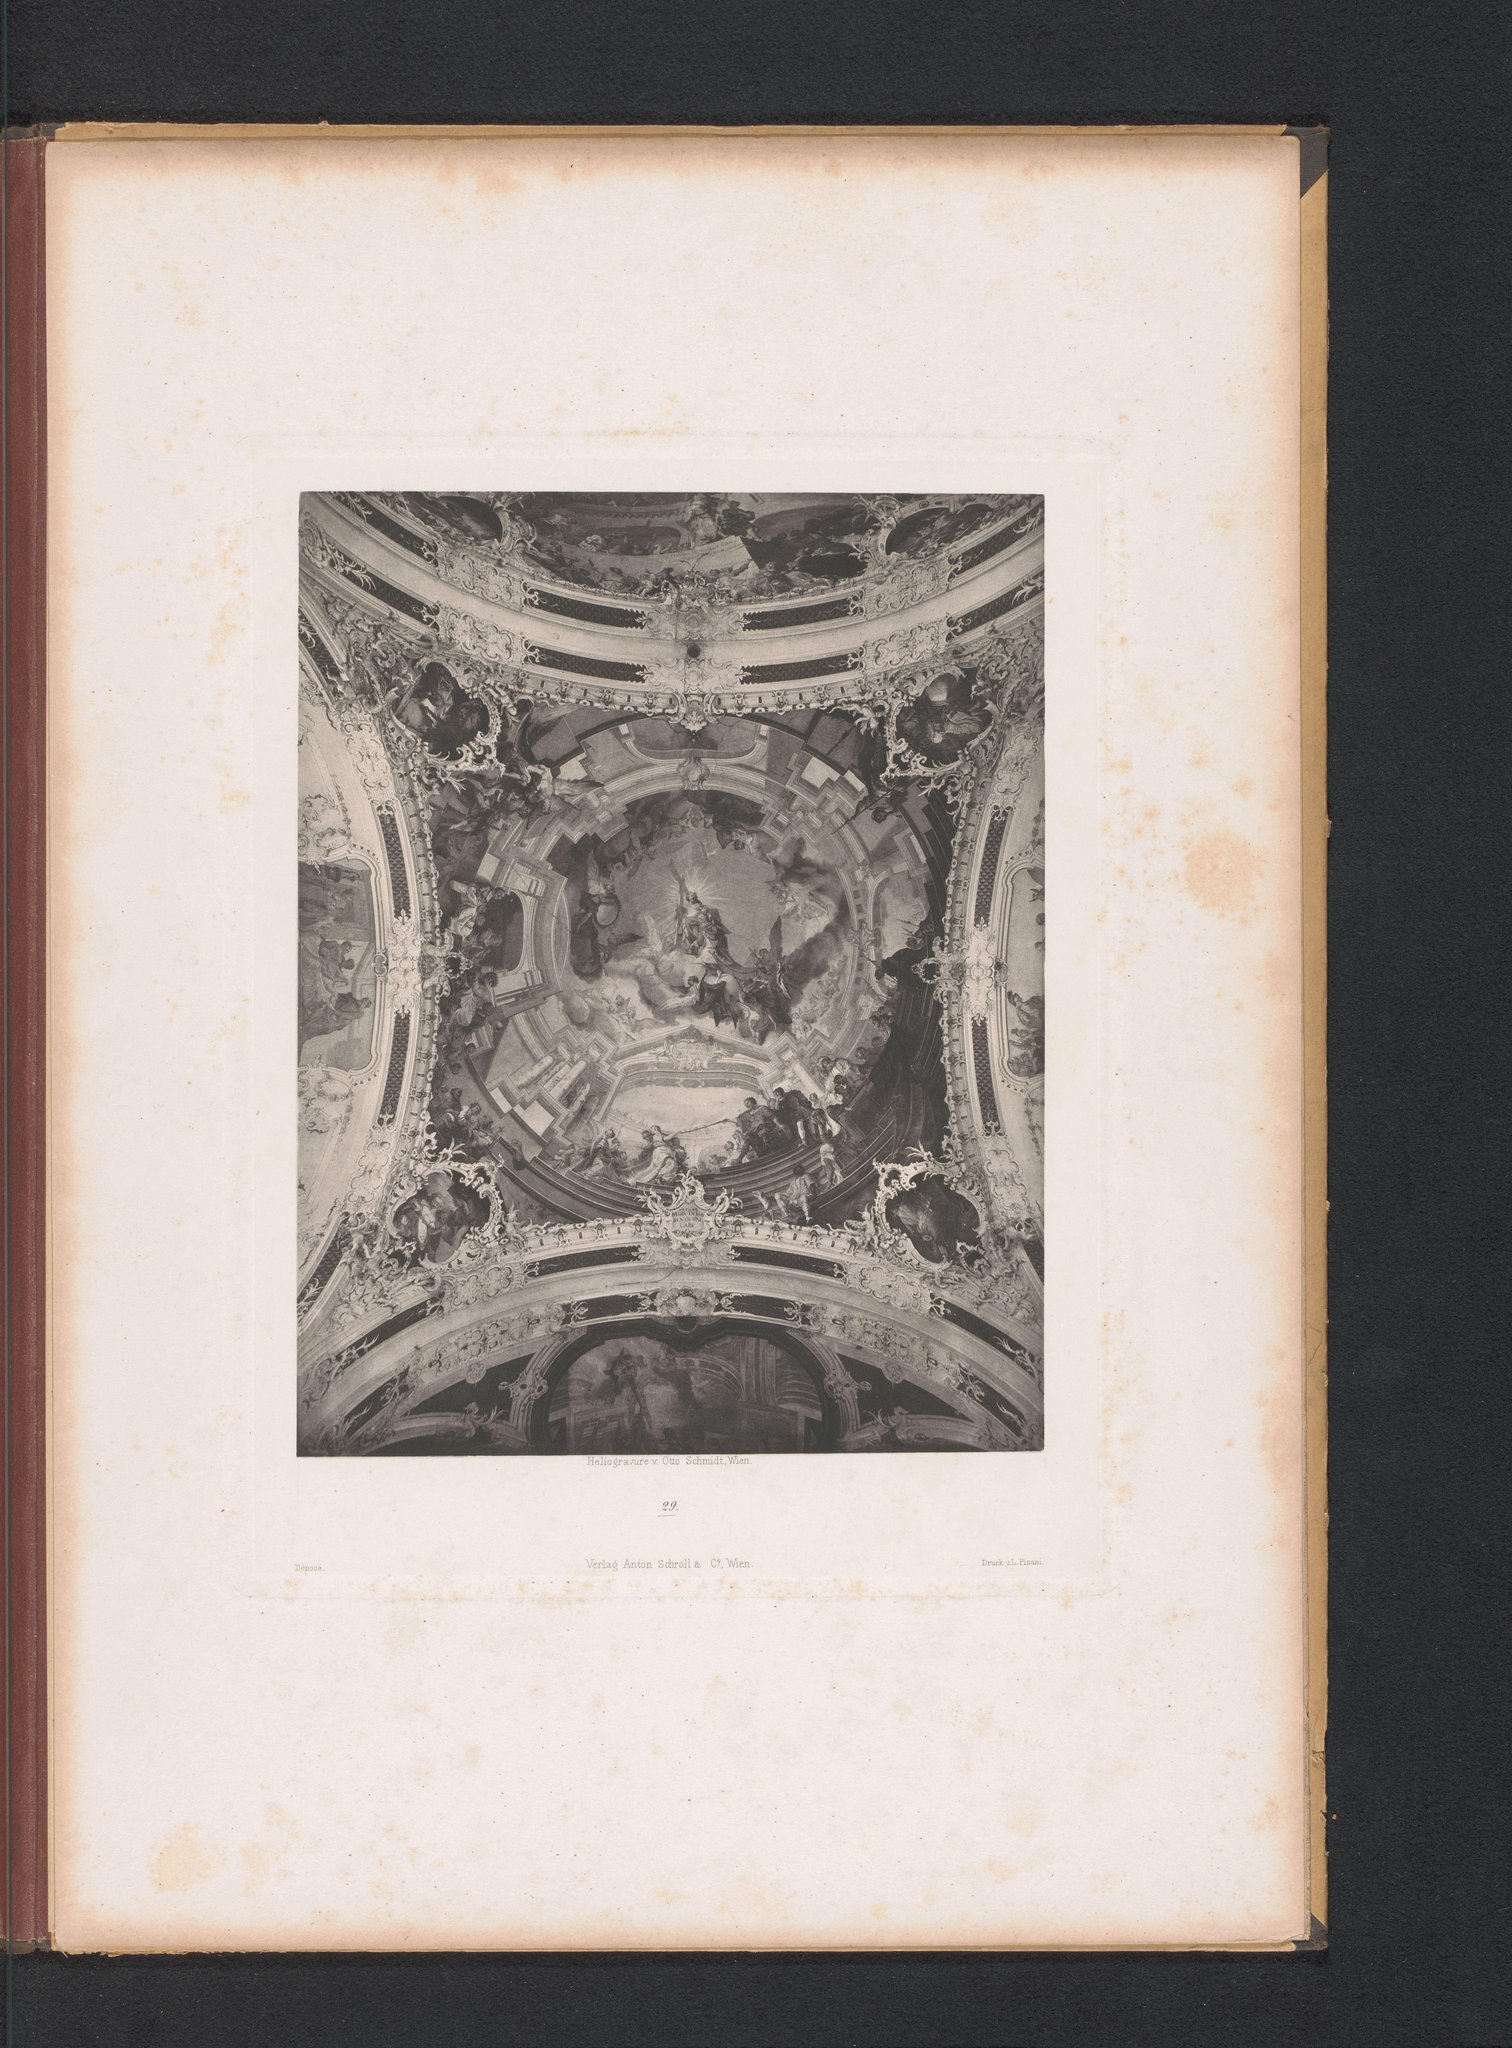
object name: photomechanical print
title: Plafondschildering in de parochiekerk van het stadsdeel Wilten in Innsbruck, Oostenrijk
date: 1888-1893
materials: paper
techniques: photoaquatint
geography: vienna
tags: interior of church, picture, painting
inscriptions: inscription: ‘Déposé.’, number: ‘29.’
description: Deze prent maakt deel uit van een omslag met twintig prenten, twee tekstbladen en een titelpagina.